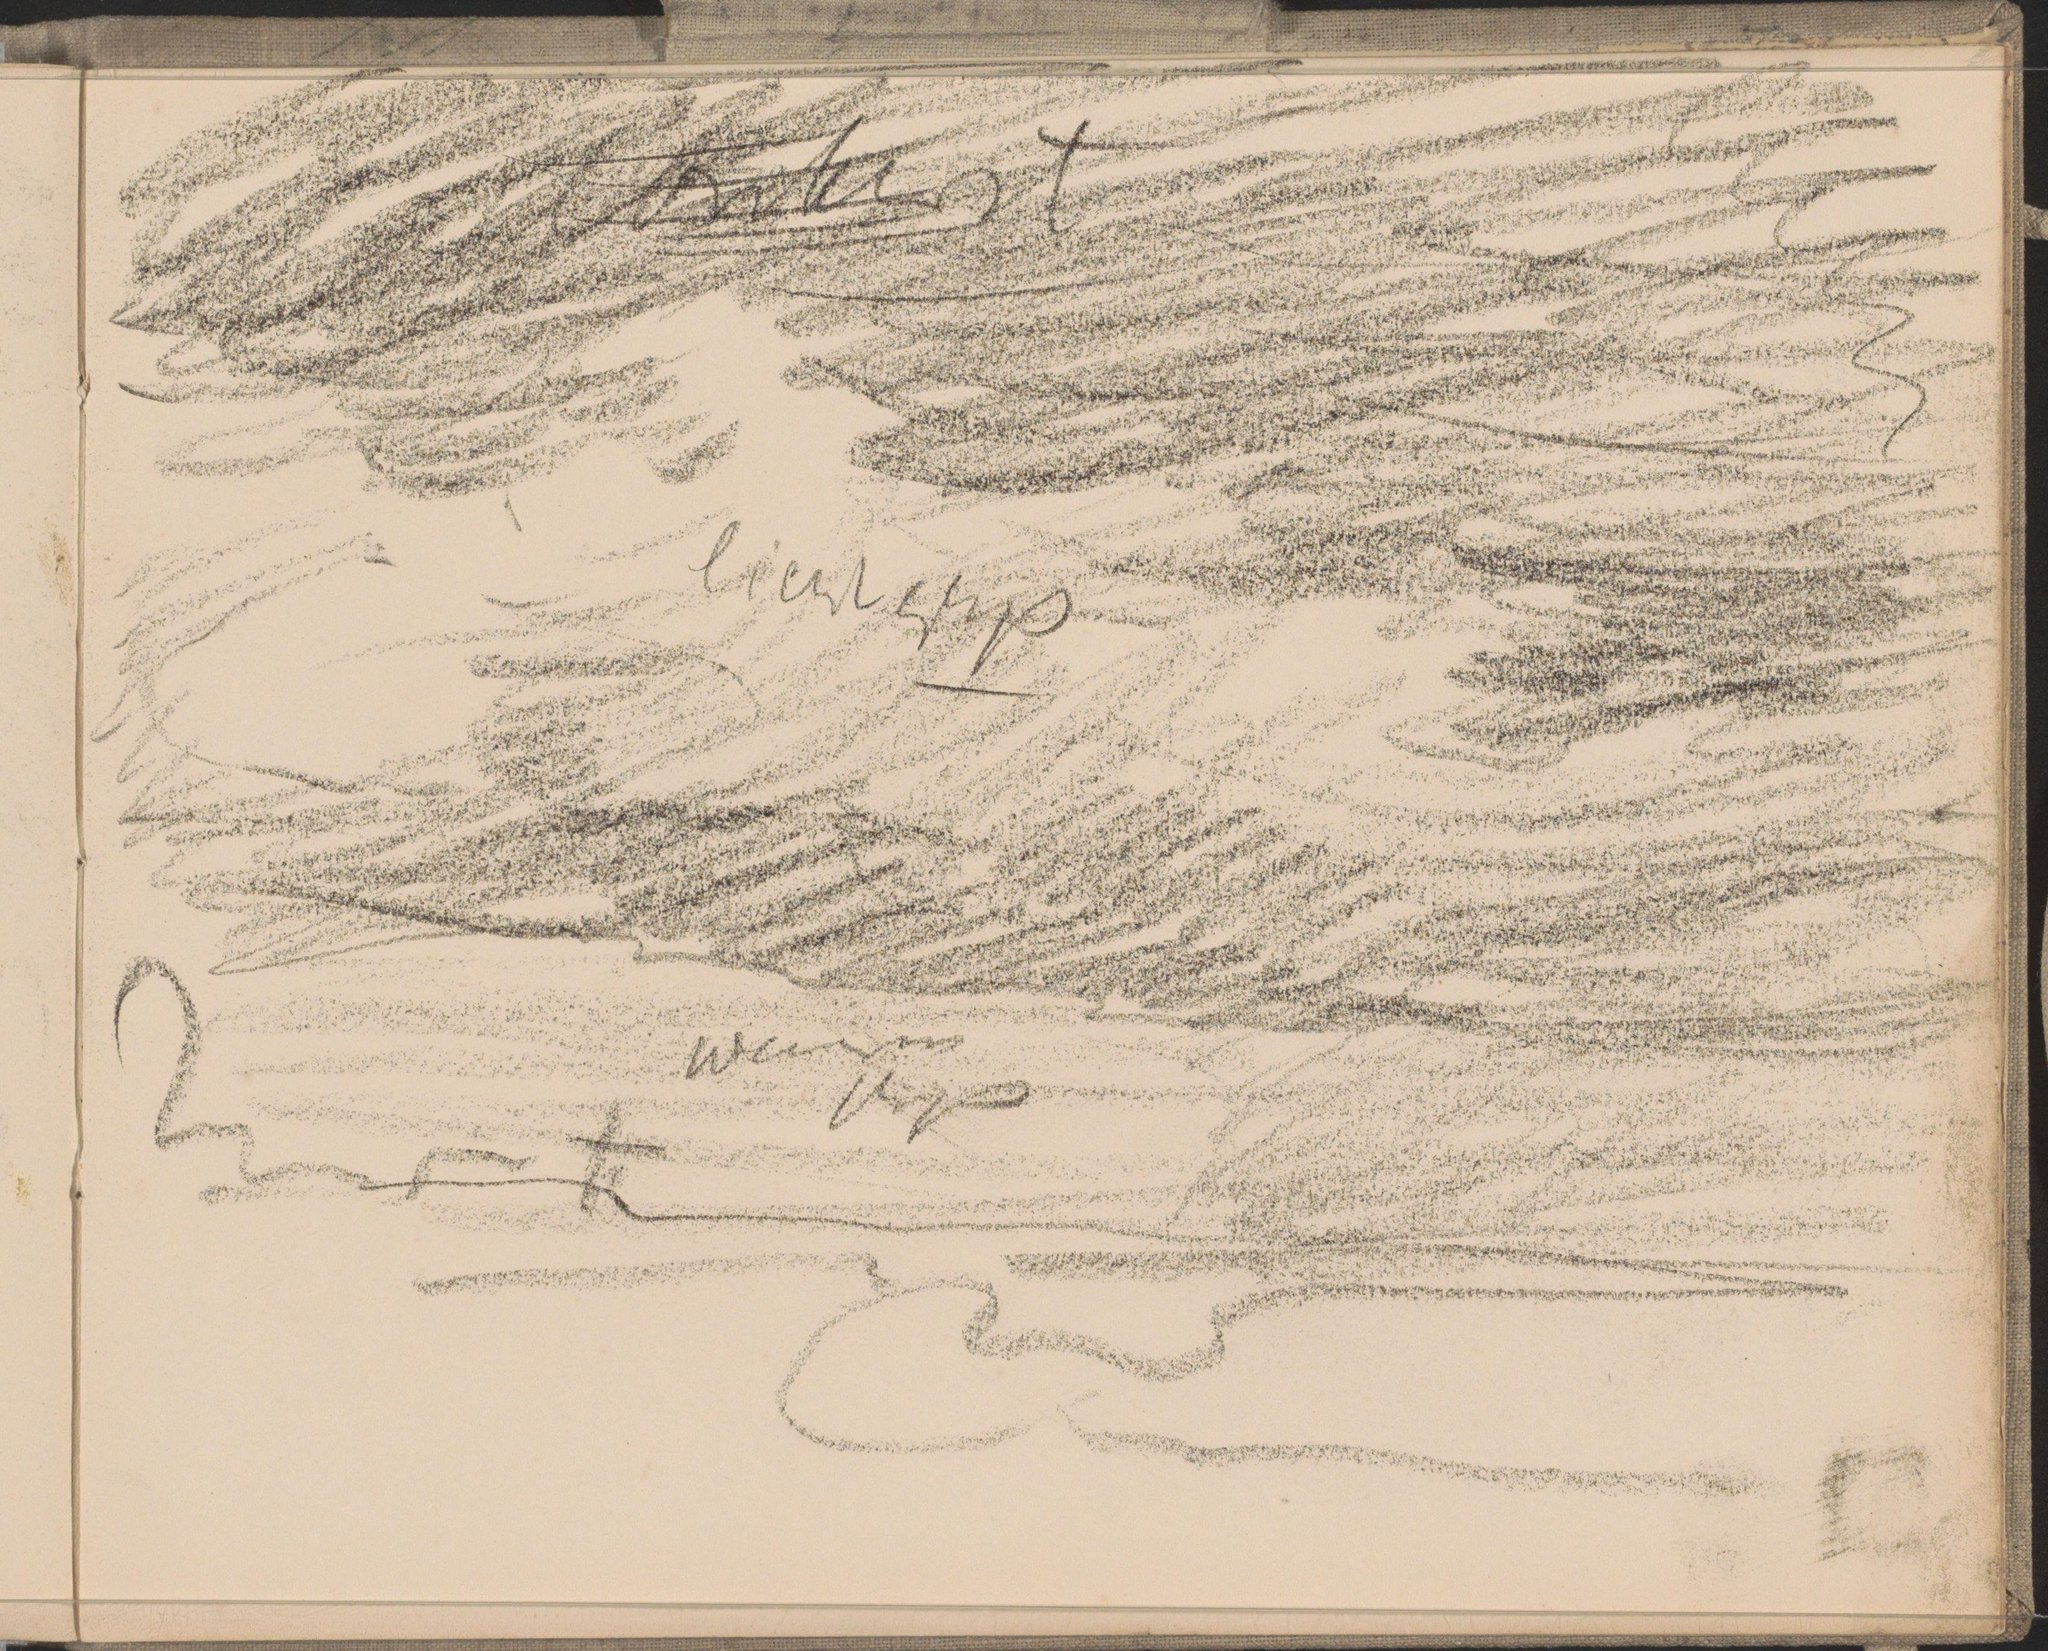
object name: sketchbook leaf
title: Landschap met wolkenlucht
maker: willem witsen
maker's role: draughtsman, painter, print maker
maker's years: 1860-1923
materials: chalk, paper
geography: wijk bij duurstede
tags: landscapes, clouds, windmill in landscape, wijk bij duurstede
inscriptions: kleurnotitie, handgeschreven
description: In de verte mogelijk een molen. Pagina 77 uit een schetsboek met 43 bladen.